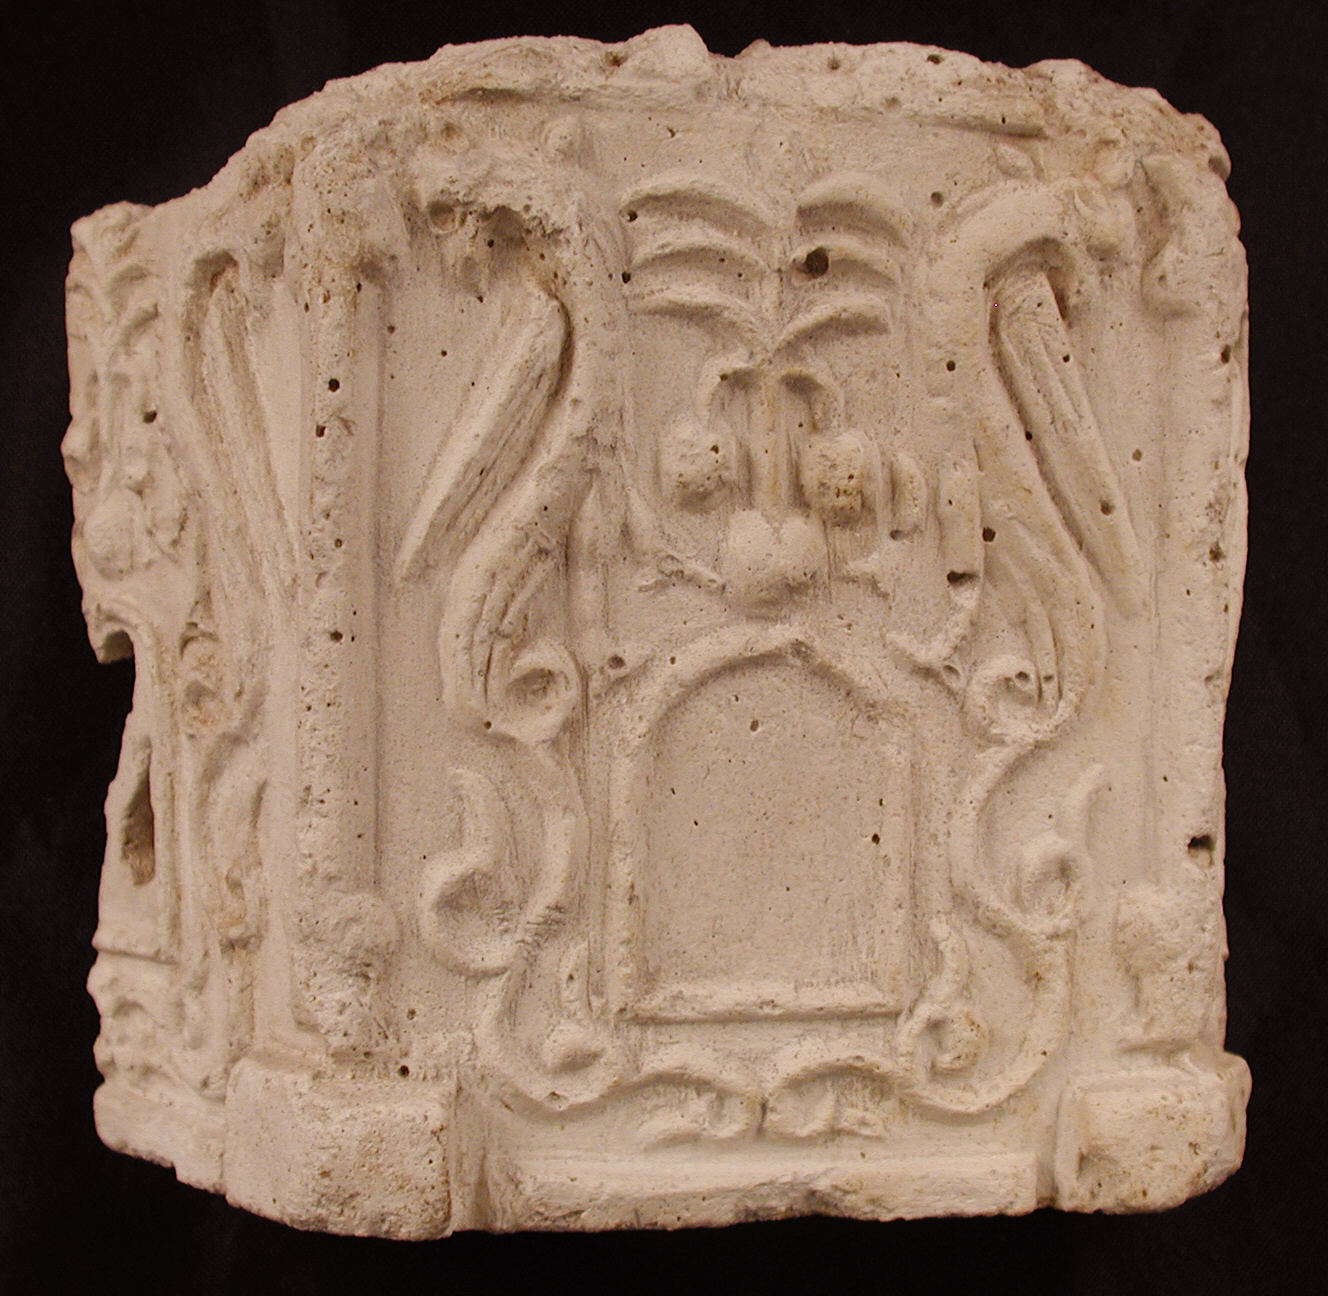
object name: fragment of a base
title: Fragment of a Base with Pair of Peacocks flanking a Palm Motif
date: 1101-1200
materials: plaster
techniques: molding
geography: iran